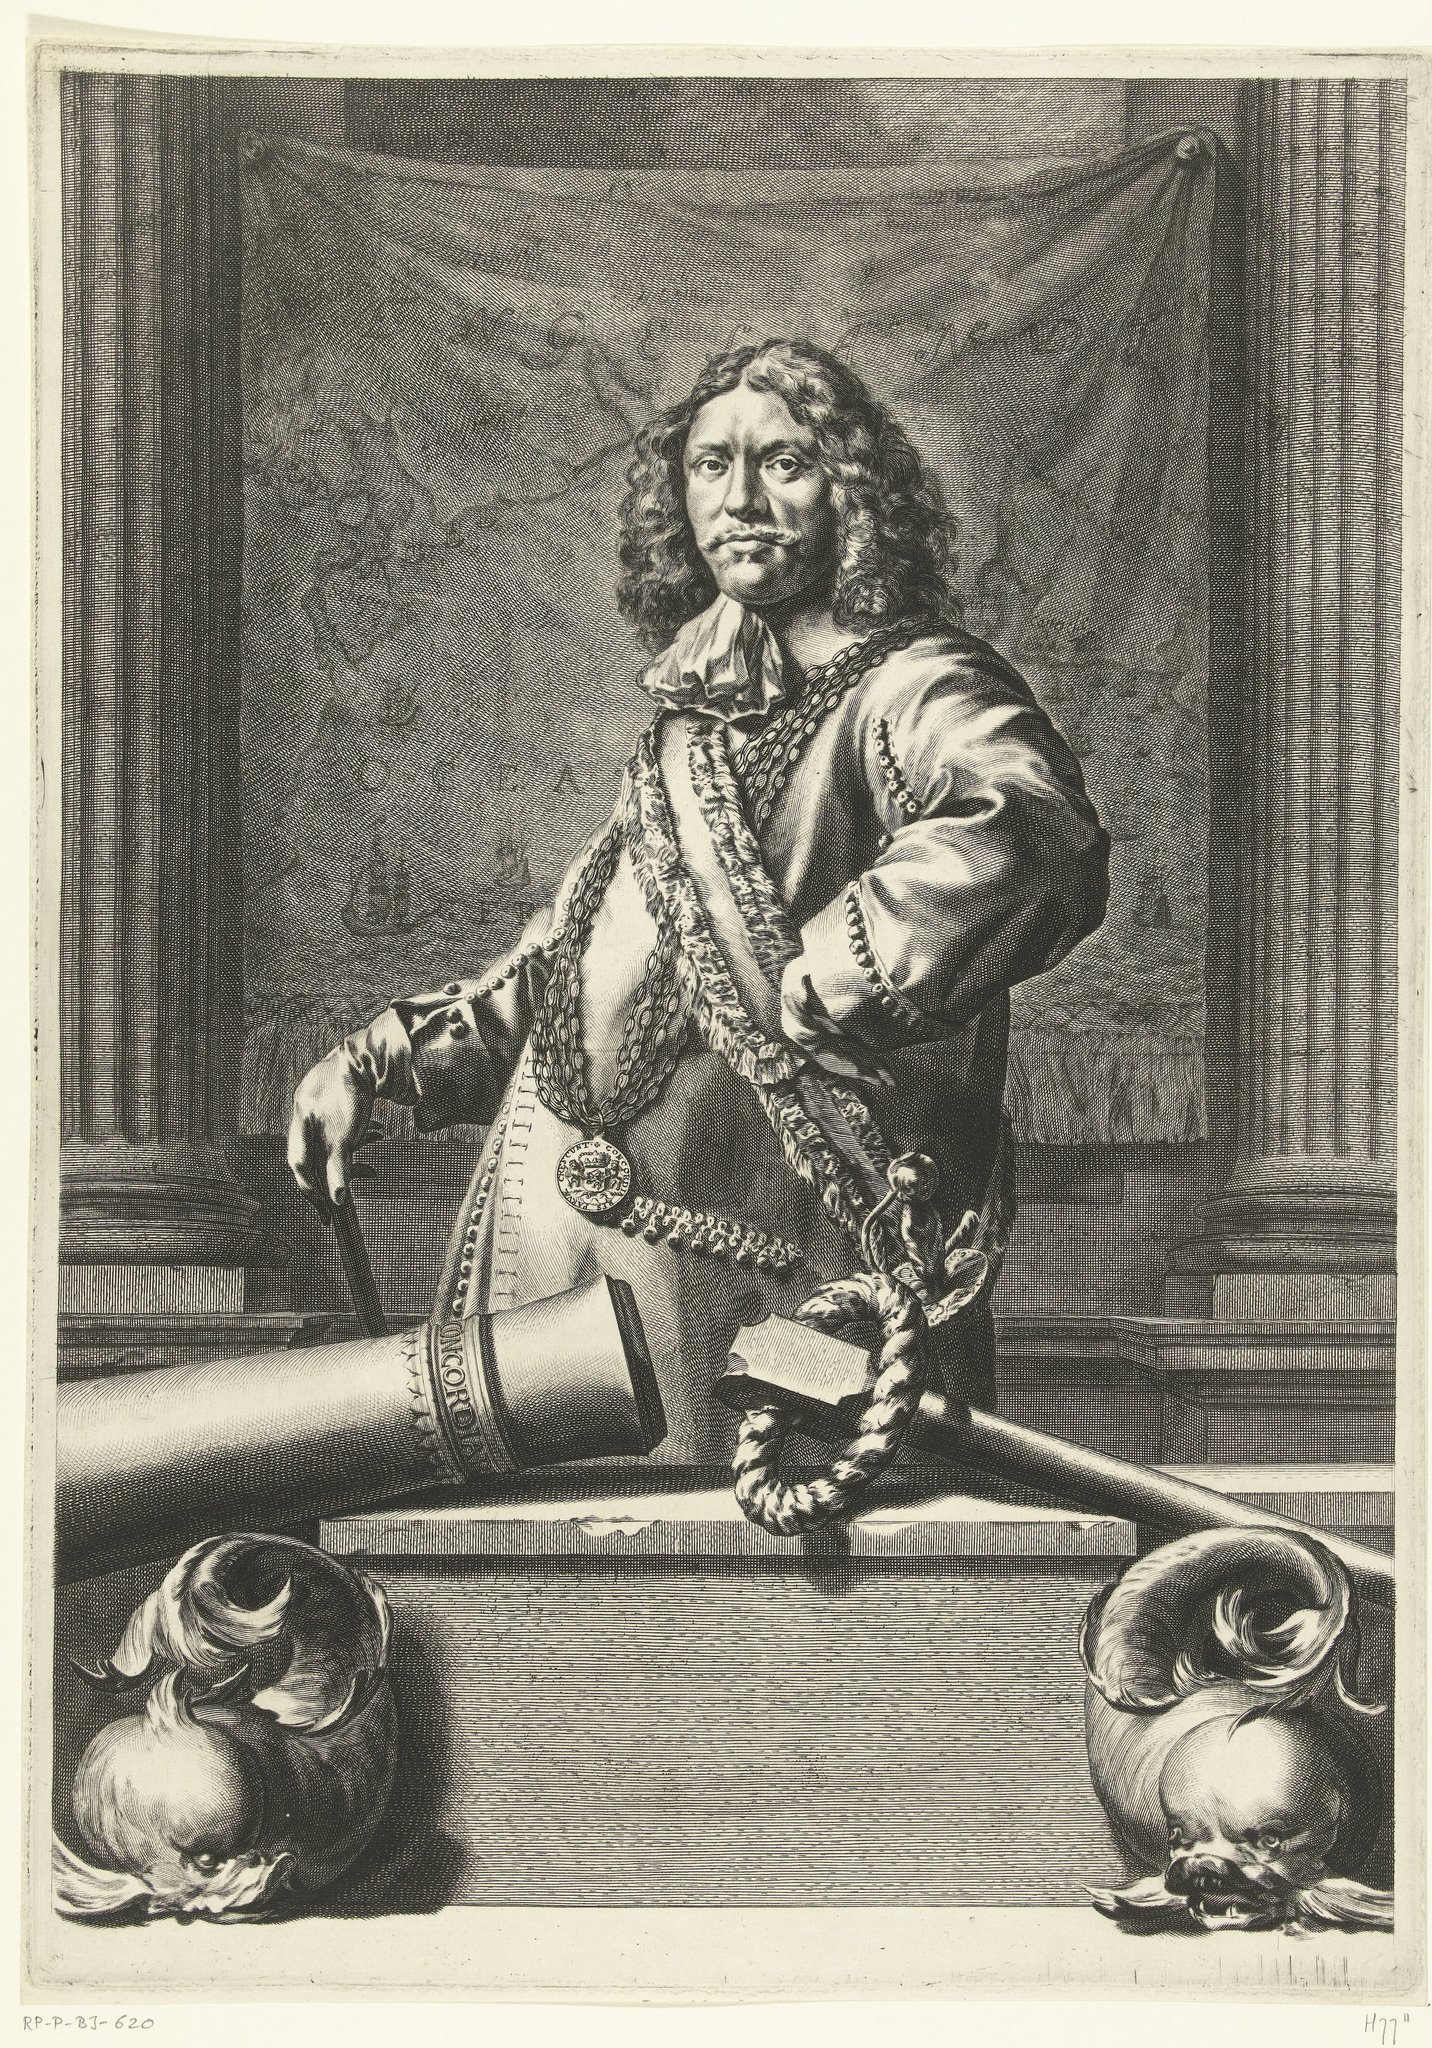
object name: print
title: Portret van David Vlugh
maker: hendrik bary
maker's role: draughtsman, print maker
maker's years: 1640-1707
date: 1657-1707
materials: paper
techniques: engraving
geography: netherlands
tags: tapestry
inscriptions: collector's mark: Lugt 2228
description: Portret van schout-bij-nacht David Vlugh. Op de achtergrond een wandtaptijt met een zeekaart.